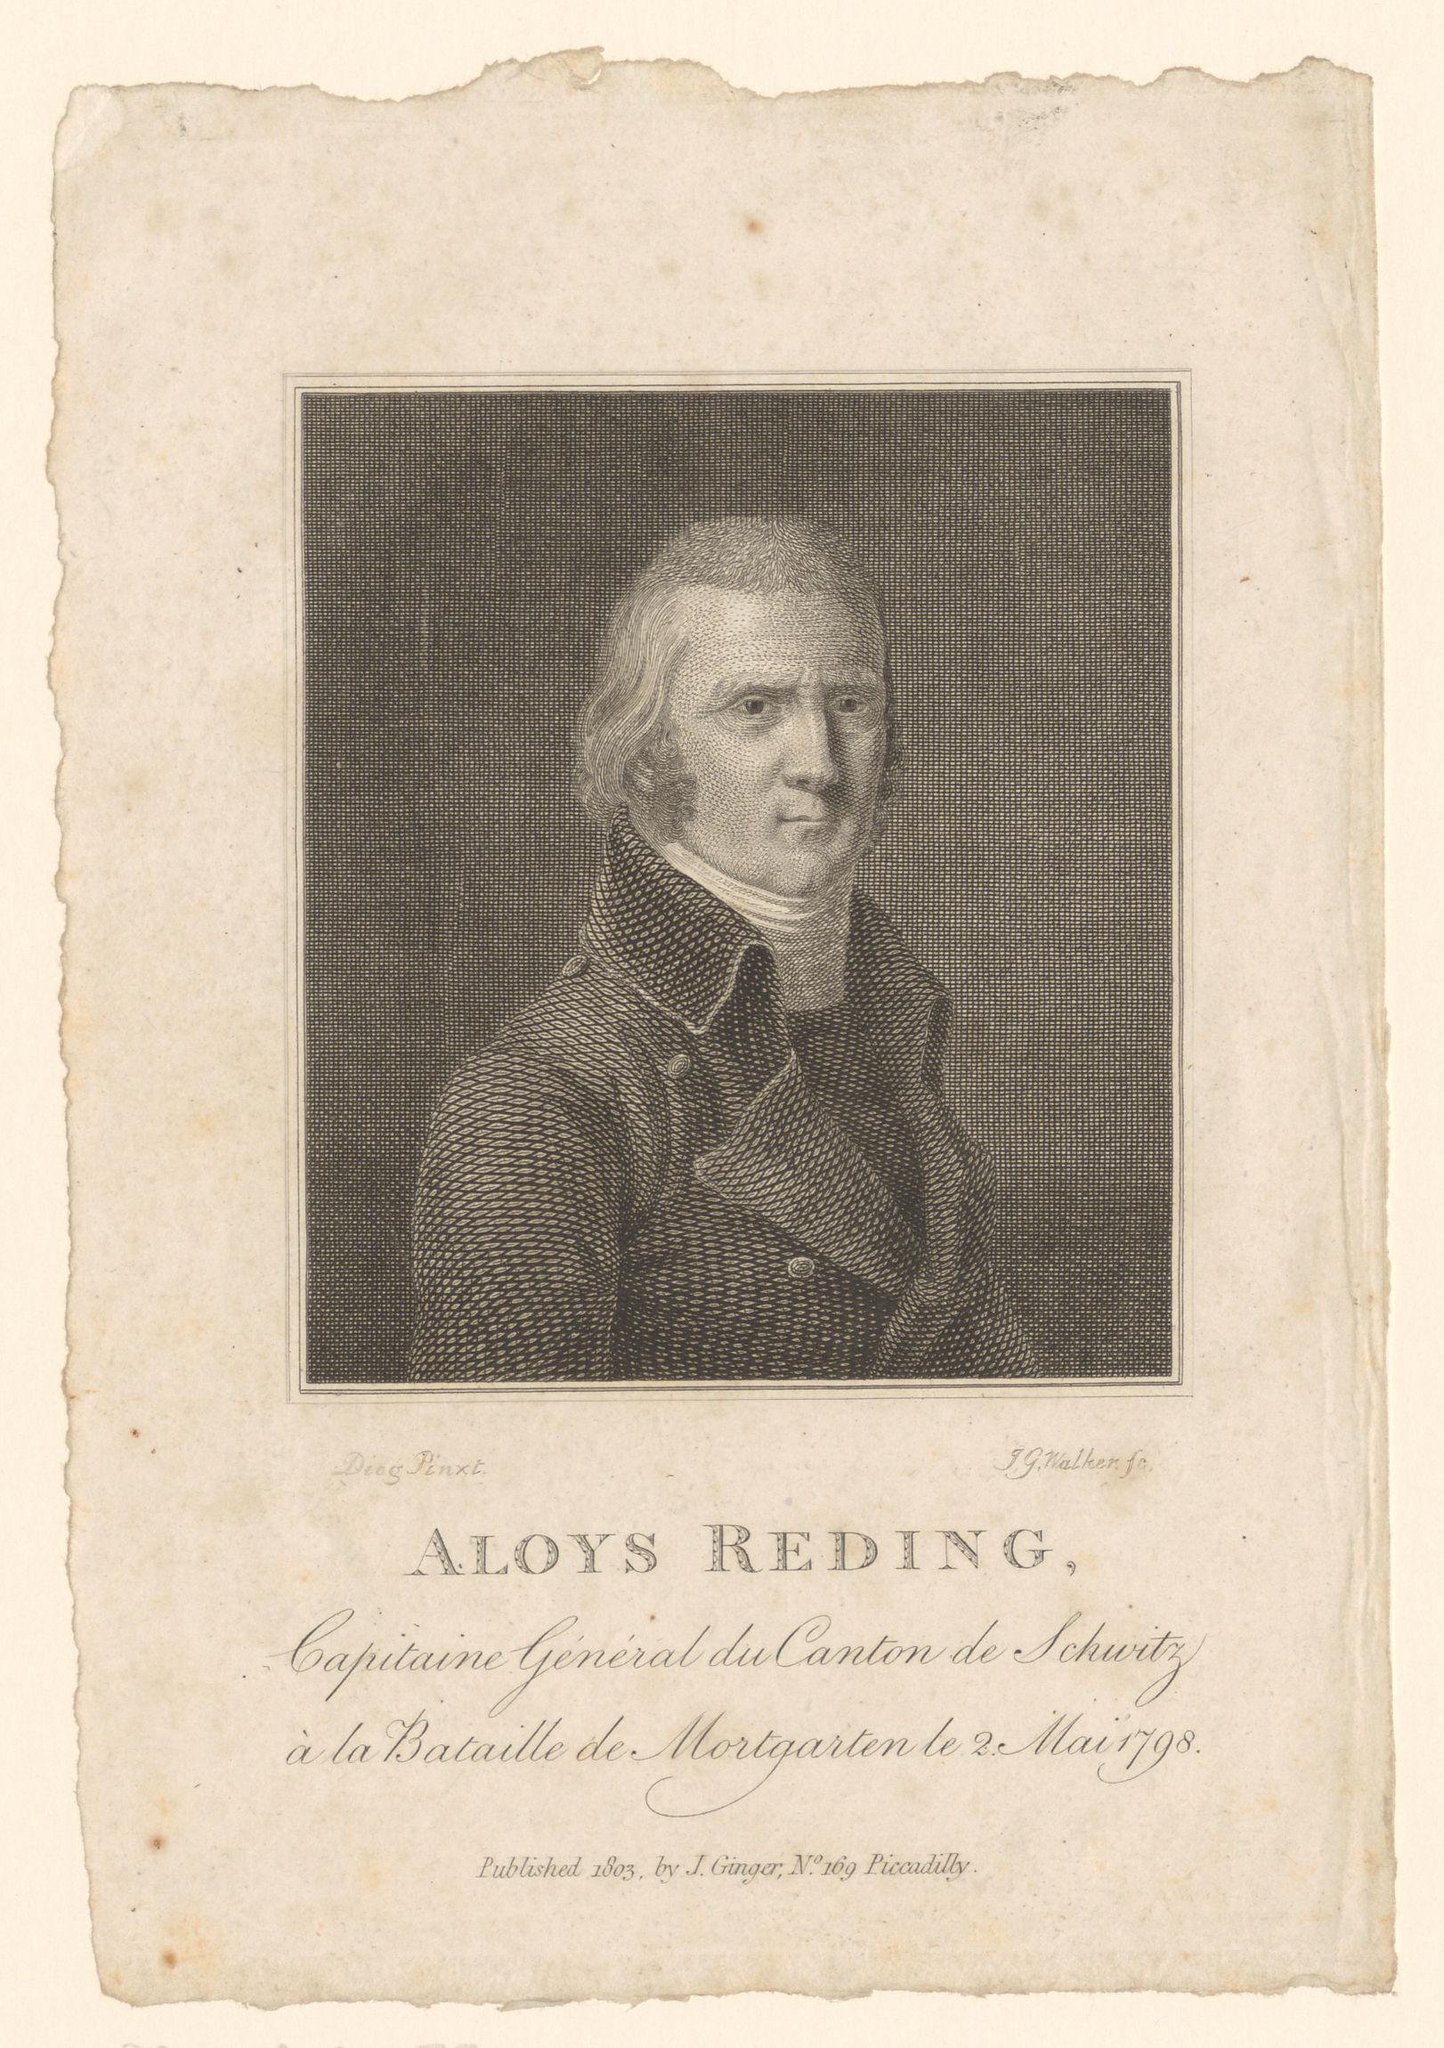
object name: print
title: Portret van Alois von Reding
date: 1803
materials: paper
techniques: engraving, etching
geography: london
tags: politician, historical persons, politician, e.g. party leader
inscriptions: collector's mark: Lugt 2228